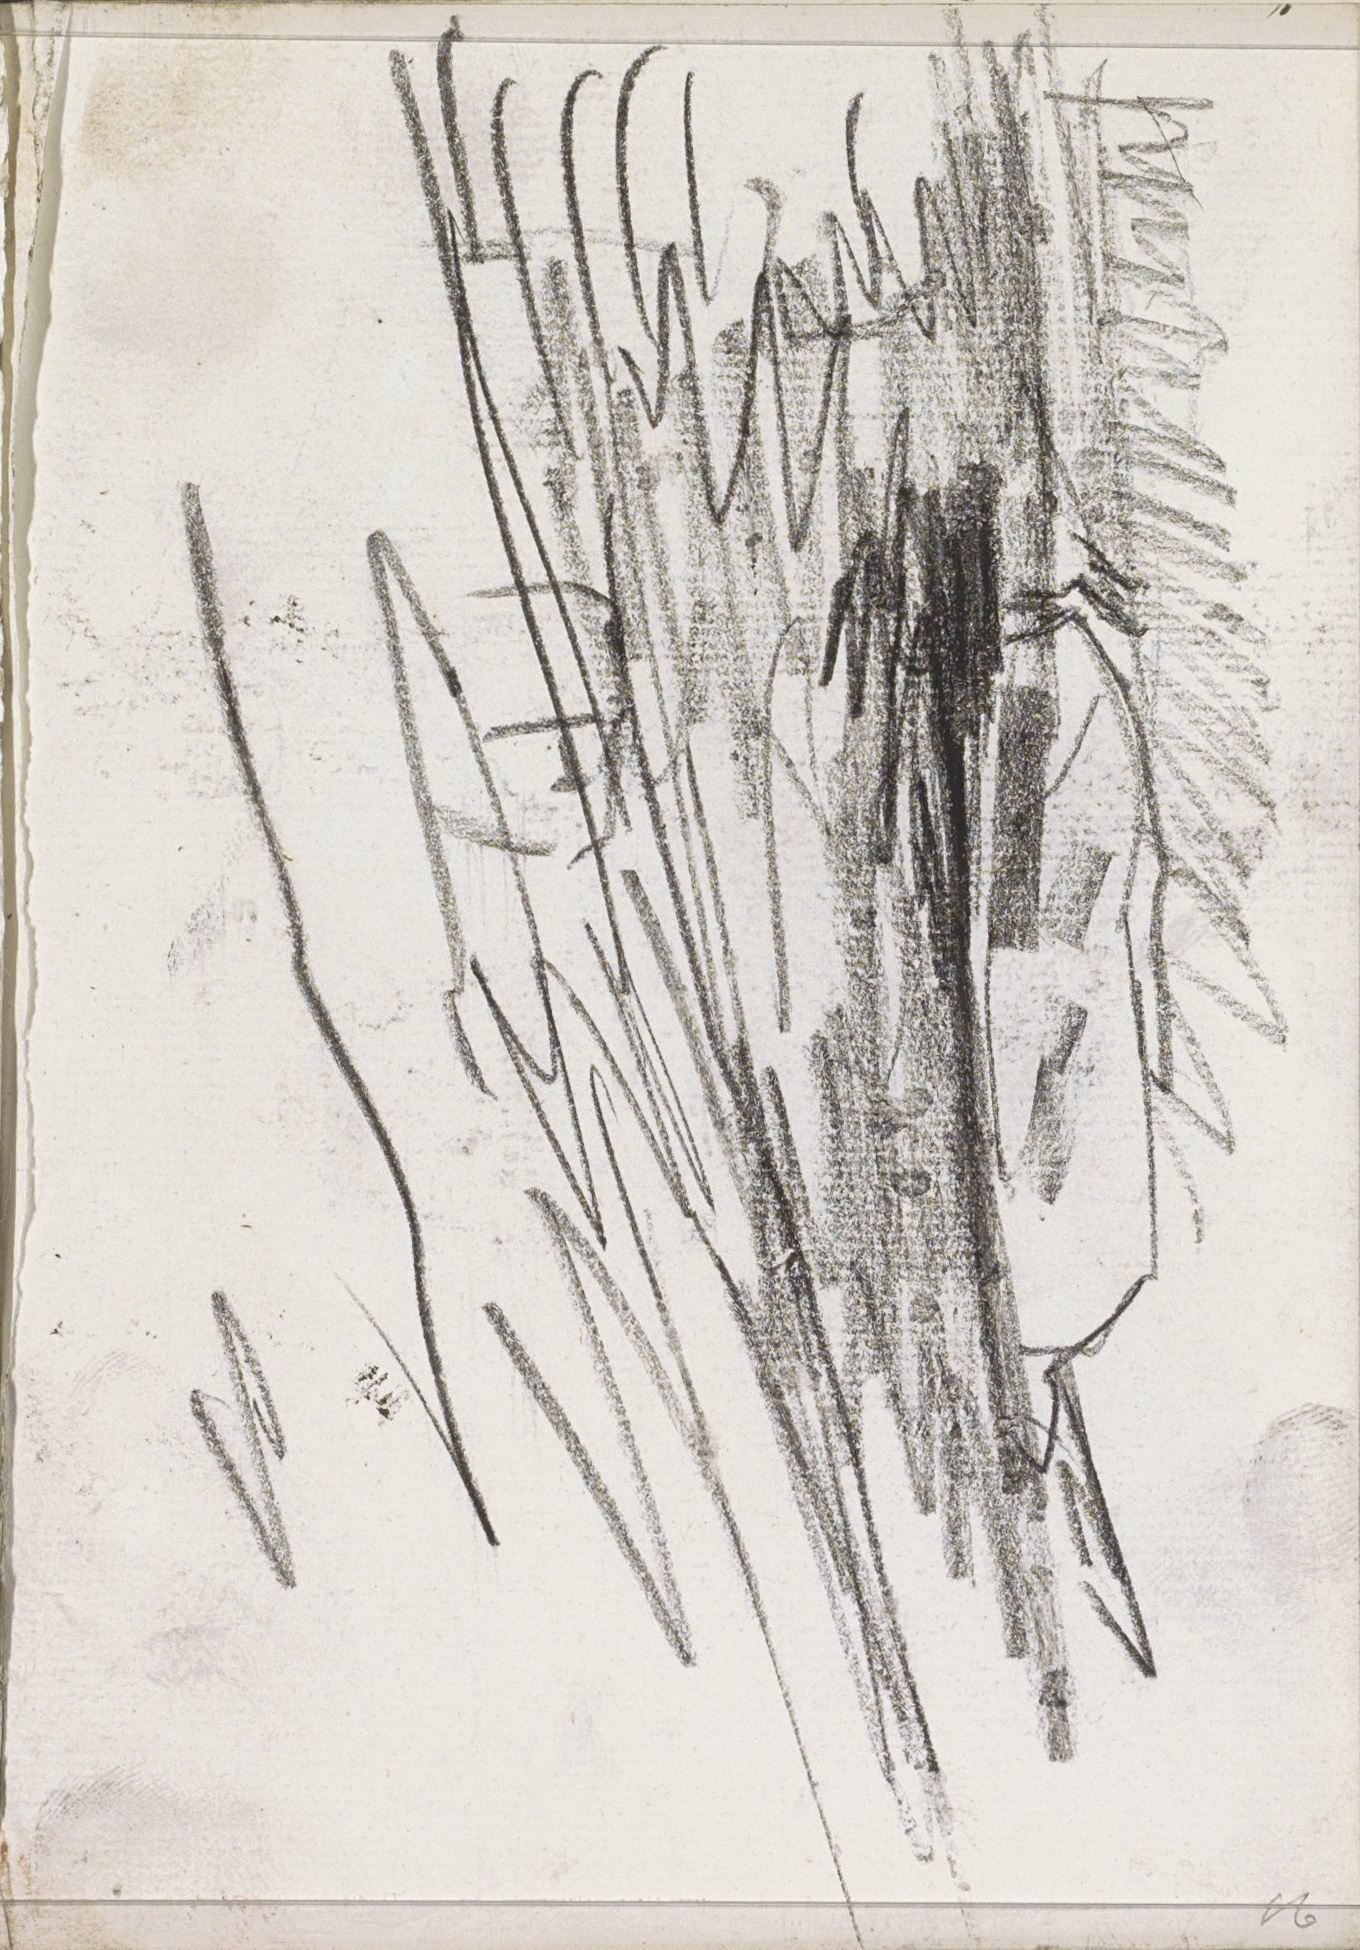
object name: sketchbook leaf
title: Studie, mogelijk van een landschap met bebouwing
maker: isaac israels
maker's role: draughtsman, painter, print maker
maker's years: 1865-1934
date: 1886-1934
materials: chalk, paper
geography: amsterdam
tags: landscapes in the temperate zone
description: Blad 16 recto uit schetsboek LV met 21 bladen.